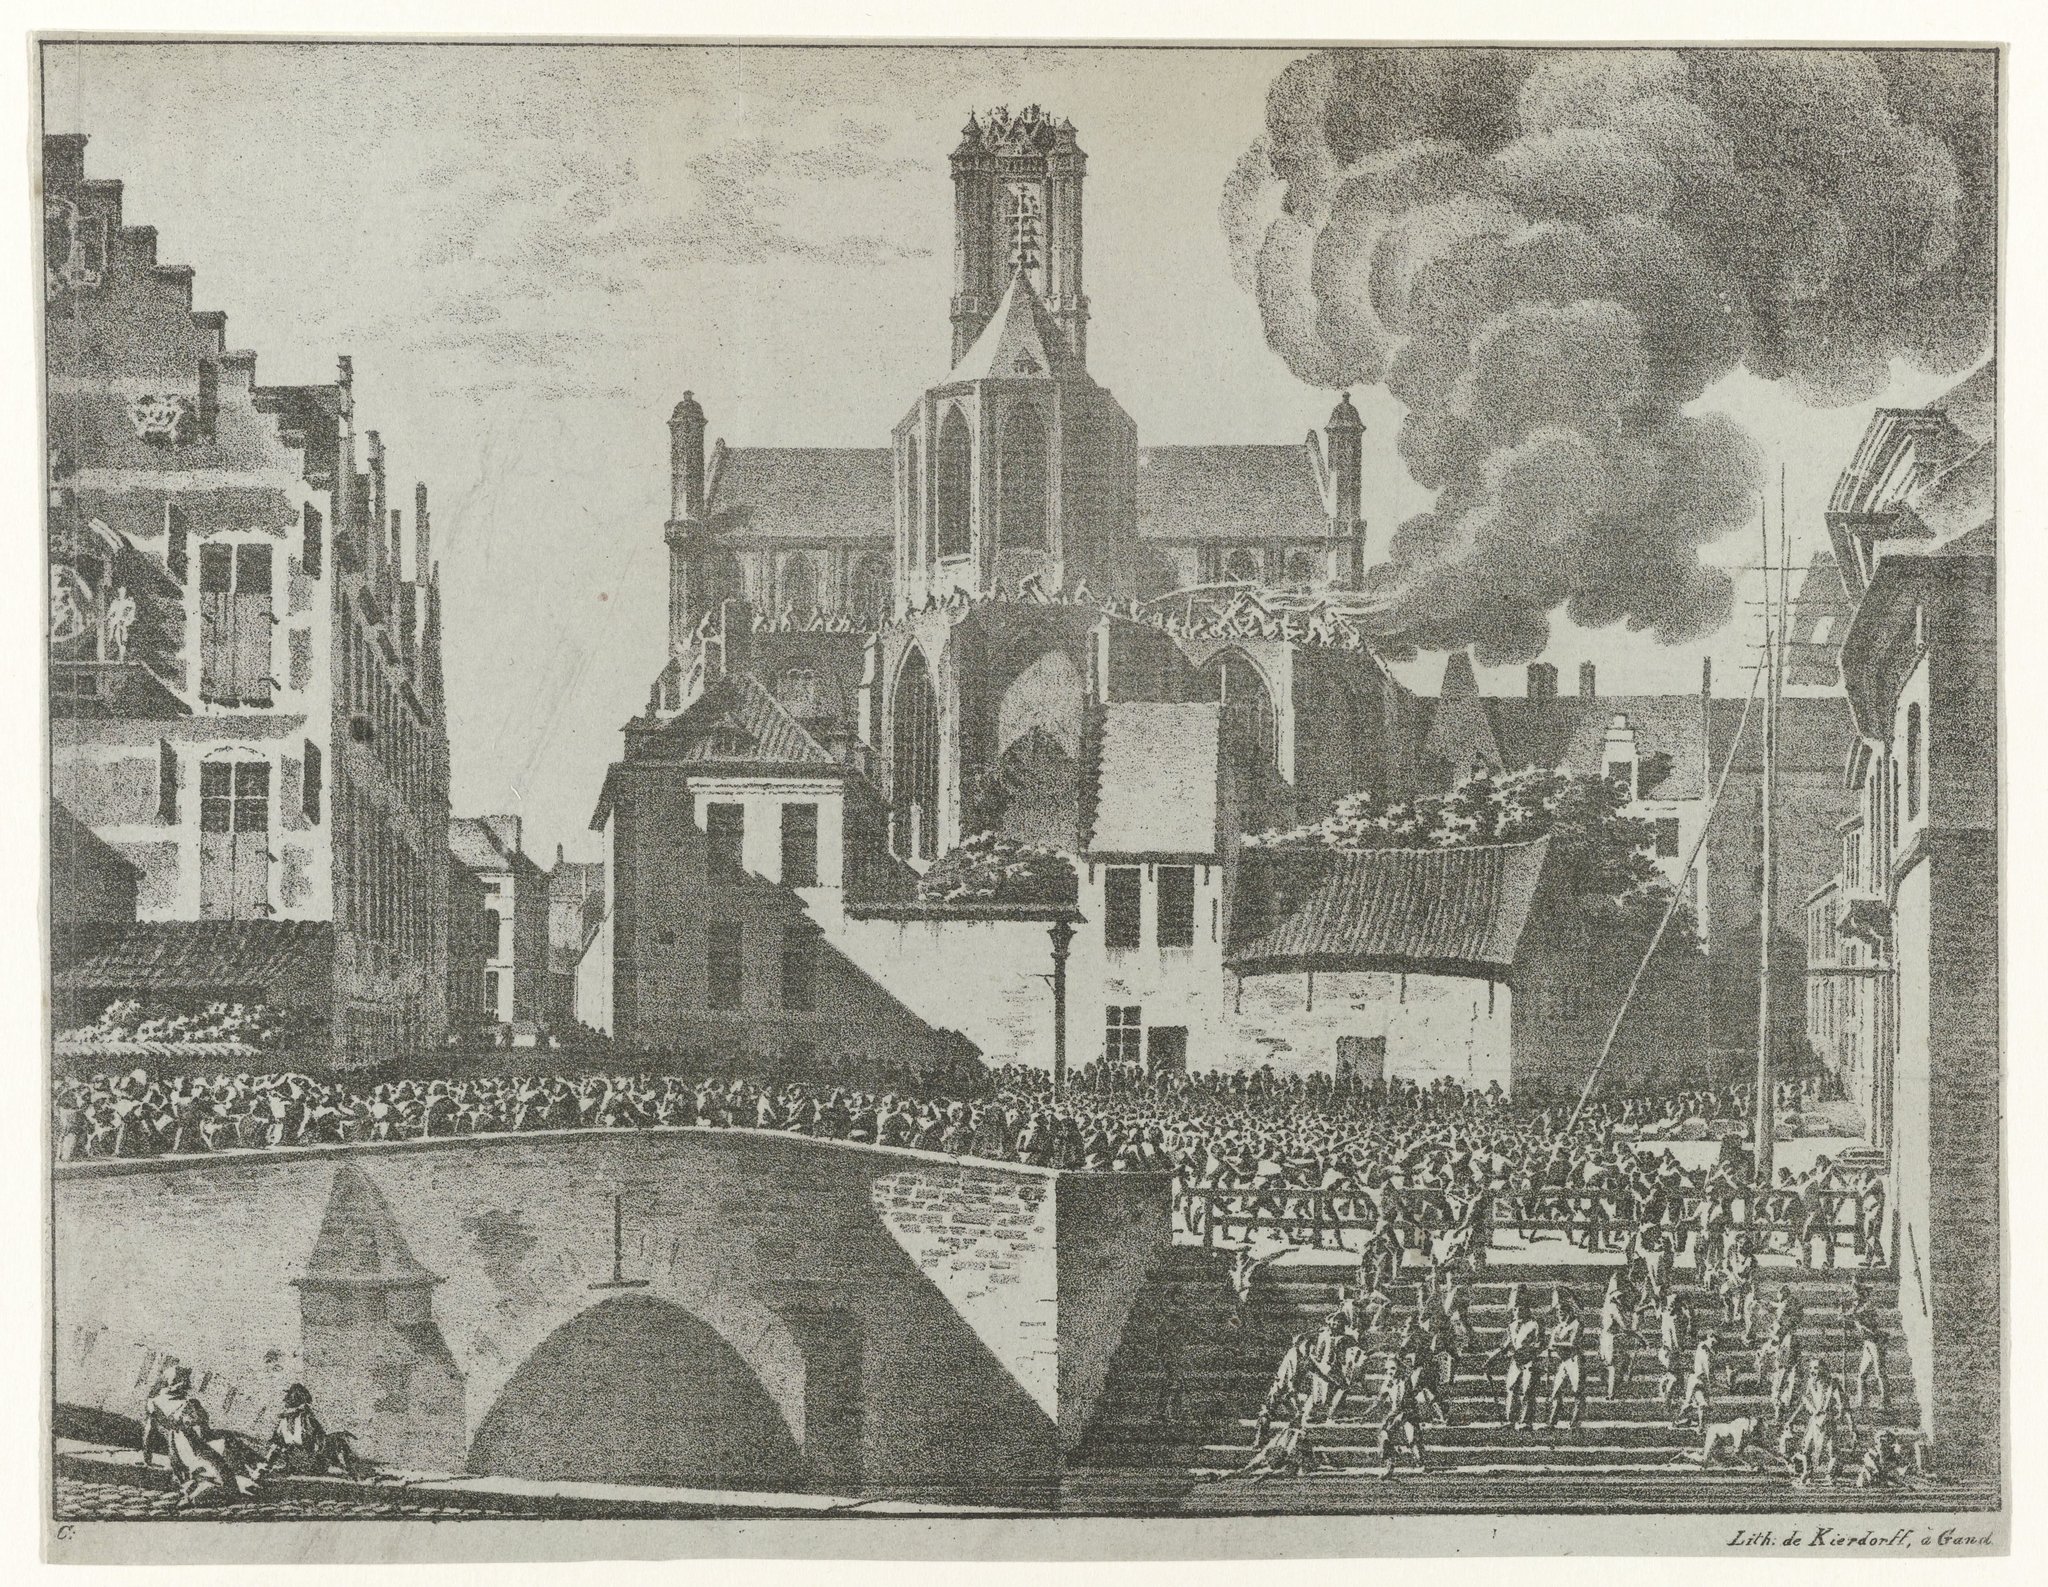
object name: print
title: Brand in de Sint-Baafskathedraal te Gent, 1822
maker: franciscus mattheus jozef kierdorff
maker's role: printer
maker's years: 1777-1855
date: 1822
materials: paper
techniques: lithograph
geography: ghent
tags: on fire, ablaze, church (exterior), ghent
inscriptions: collector's mark: Lugt 2228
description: Brand in de Sint-Baafskathedraal te Gent, 11 september 1822. Op de voorgrond een grote menigte toeschouwers en mensen die in de gracht emmers water vullen.